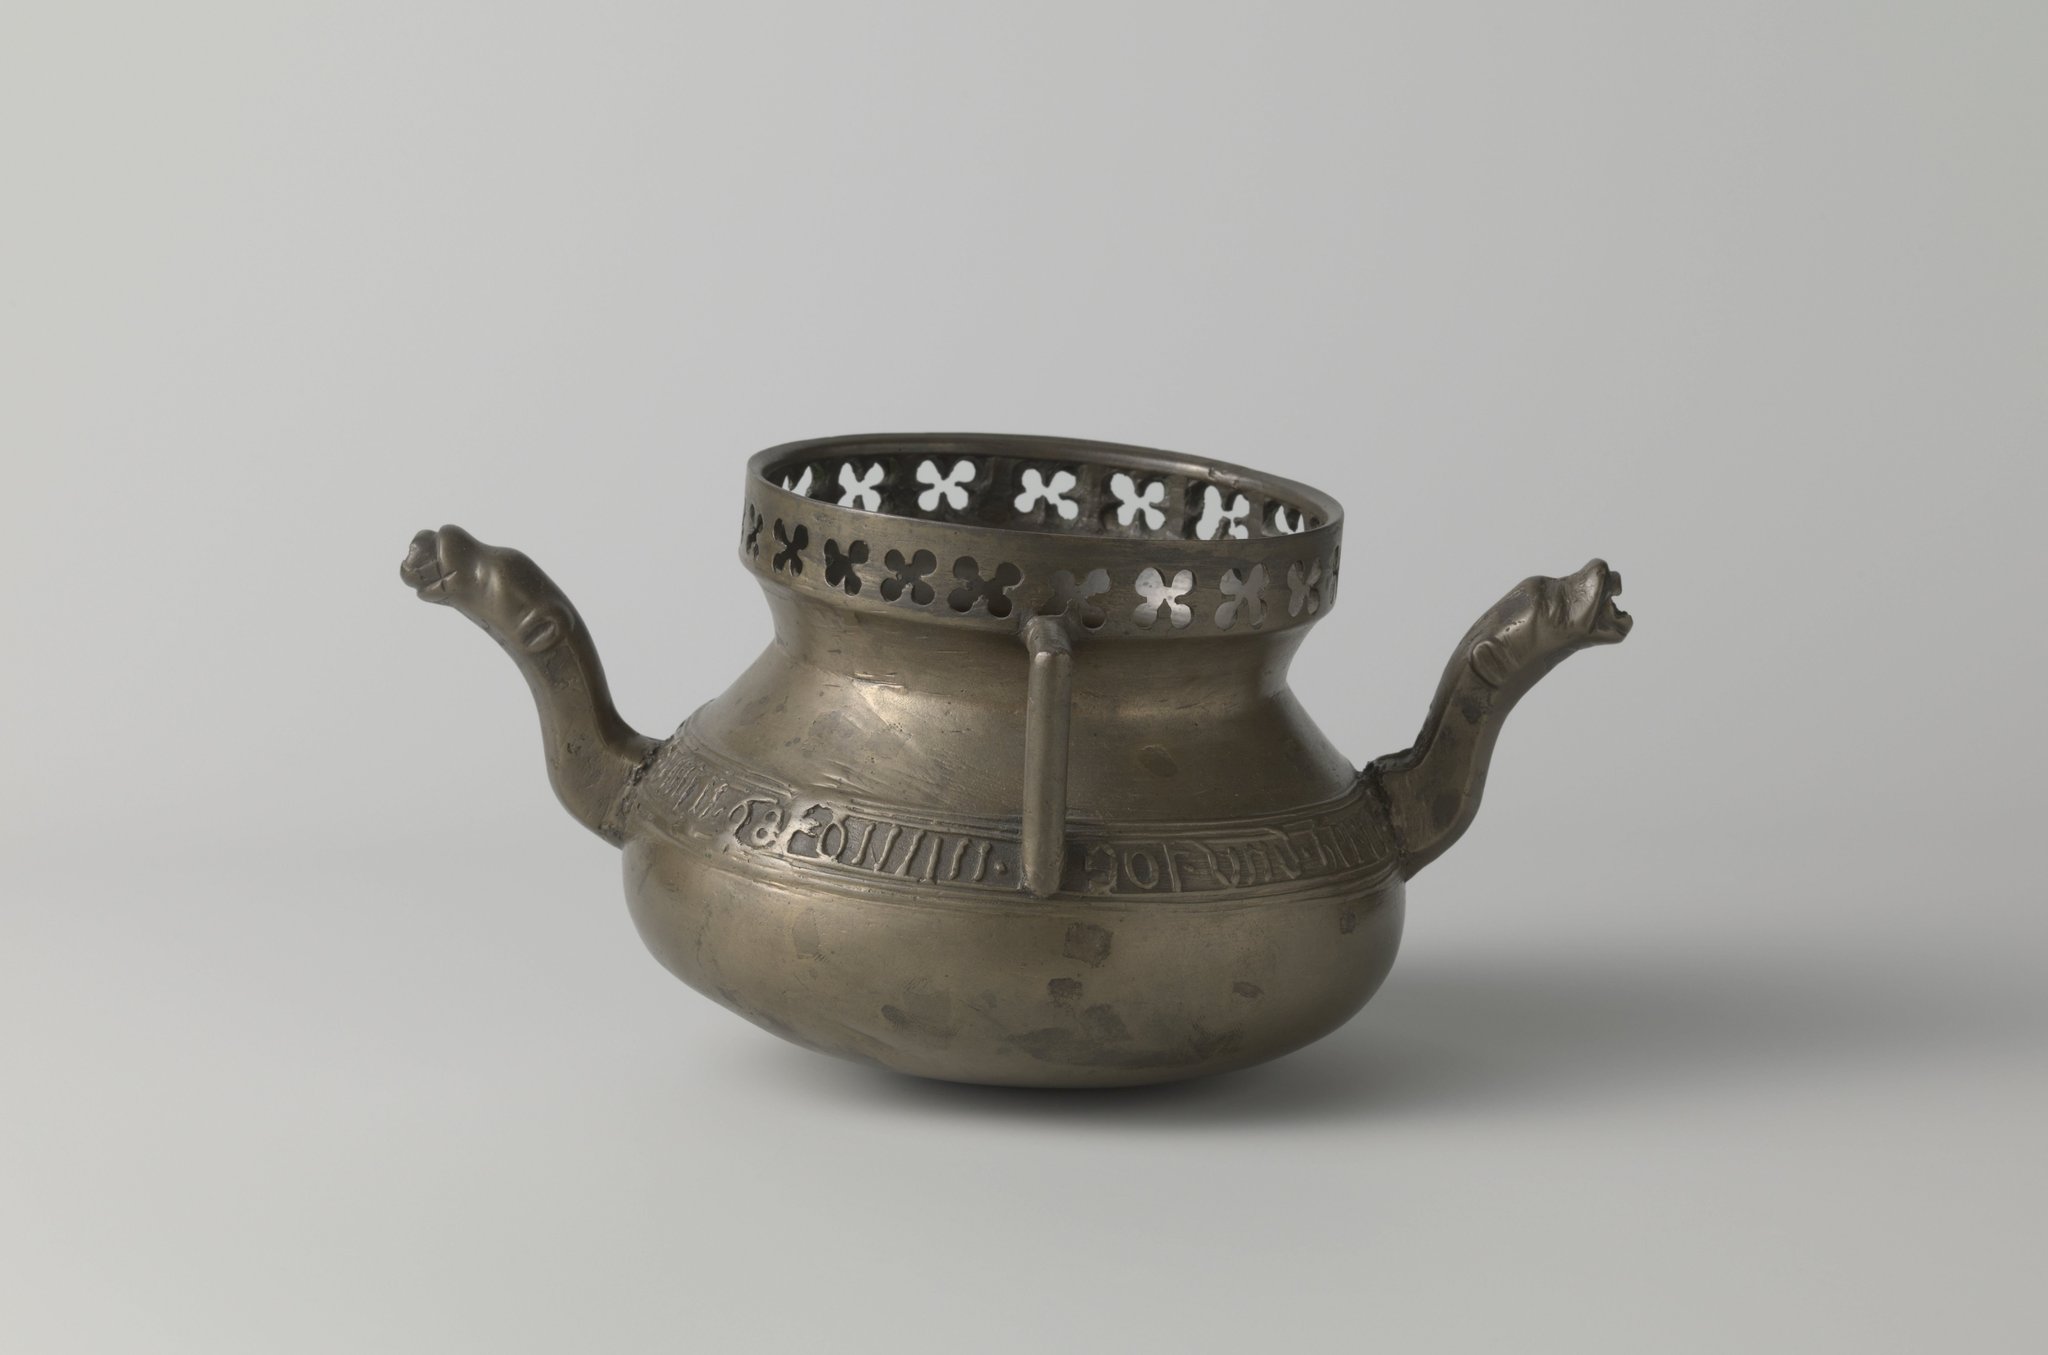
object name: lavabo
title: Lavabo met vierpassen en religieuze tekst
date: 1450-1550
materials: copper alloy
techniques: casting, manufacturing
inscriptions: inscription: ‘omin.got.und.her.e (?) .bid.di. [...] wolt un.im.gelove.un.e.v.IIILII.68’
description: Lavabo (hanging water vessel). Brass. Westphalia, c. 1450 - 1550.